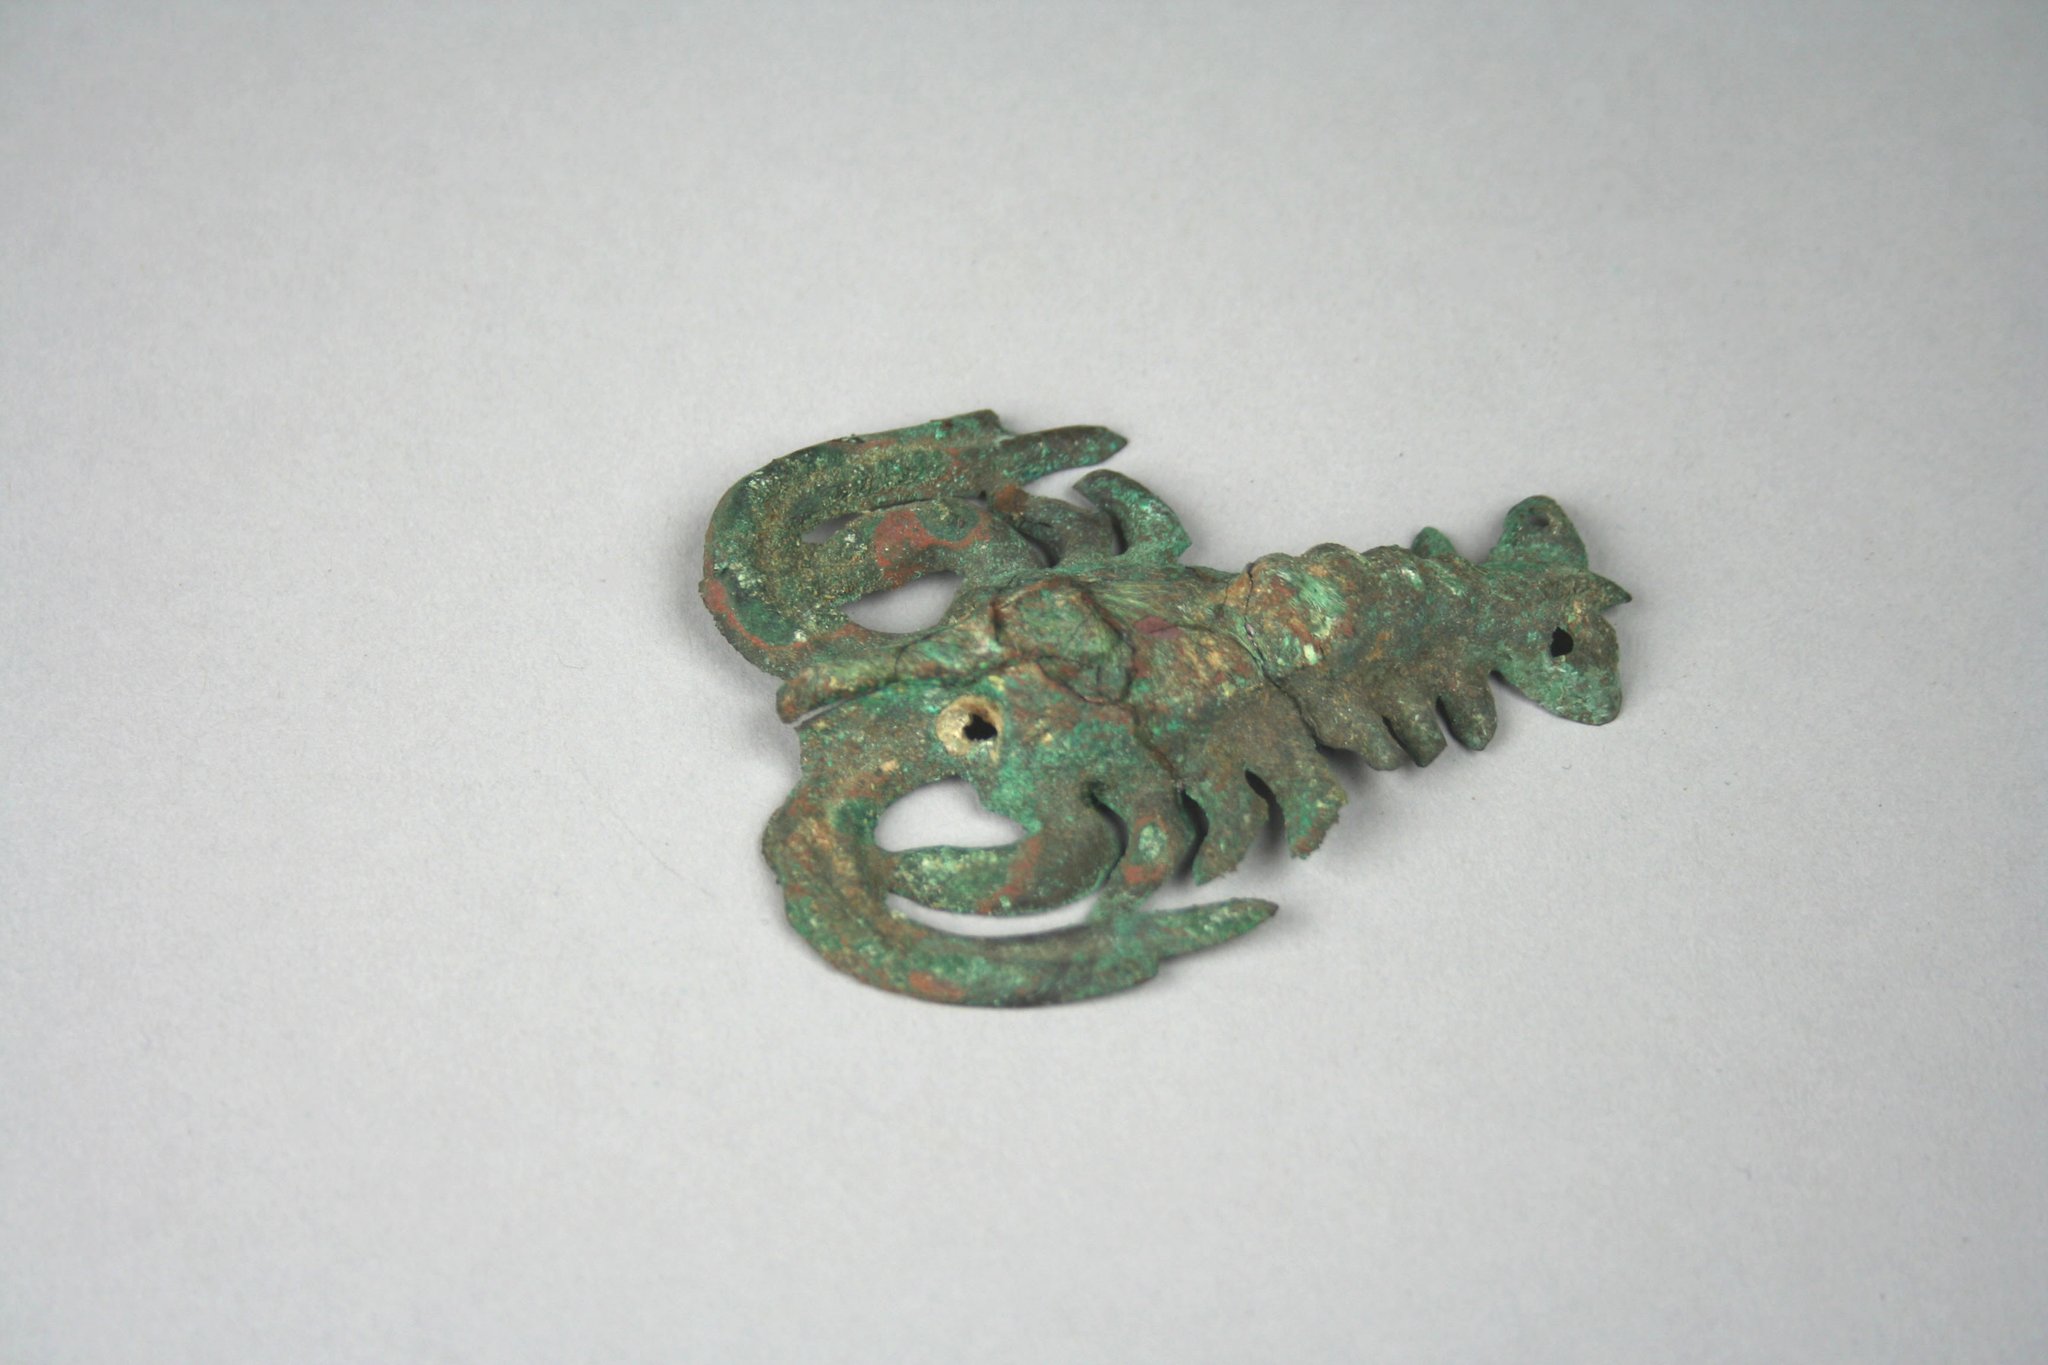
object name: ornament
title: Animal Ornament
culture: moche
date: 501-700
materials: shell, metal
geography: peru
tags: insects